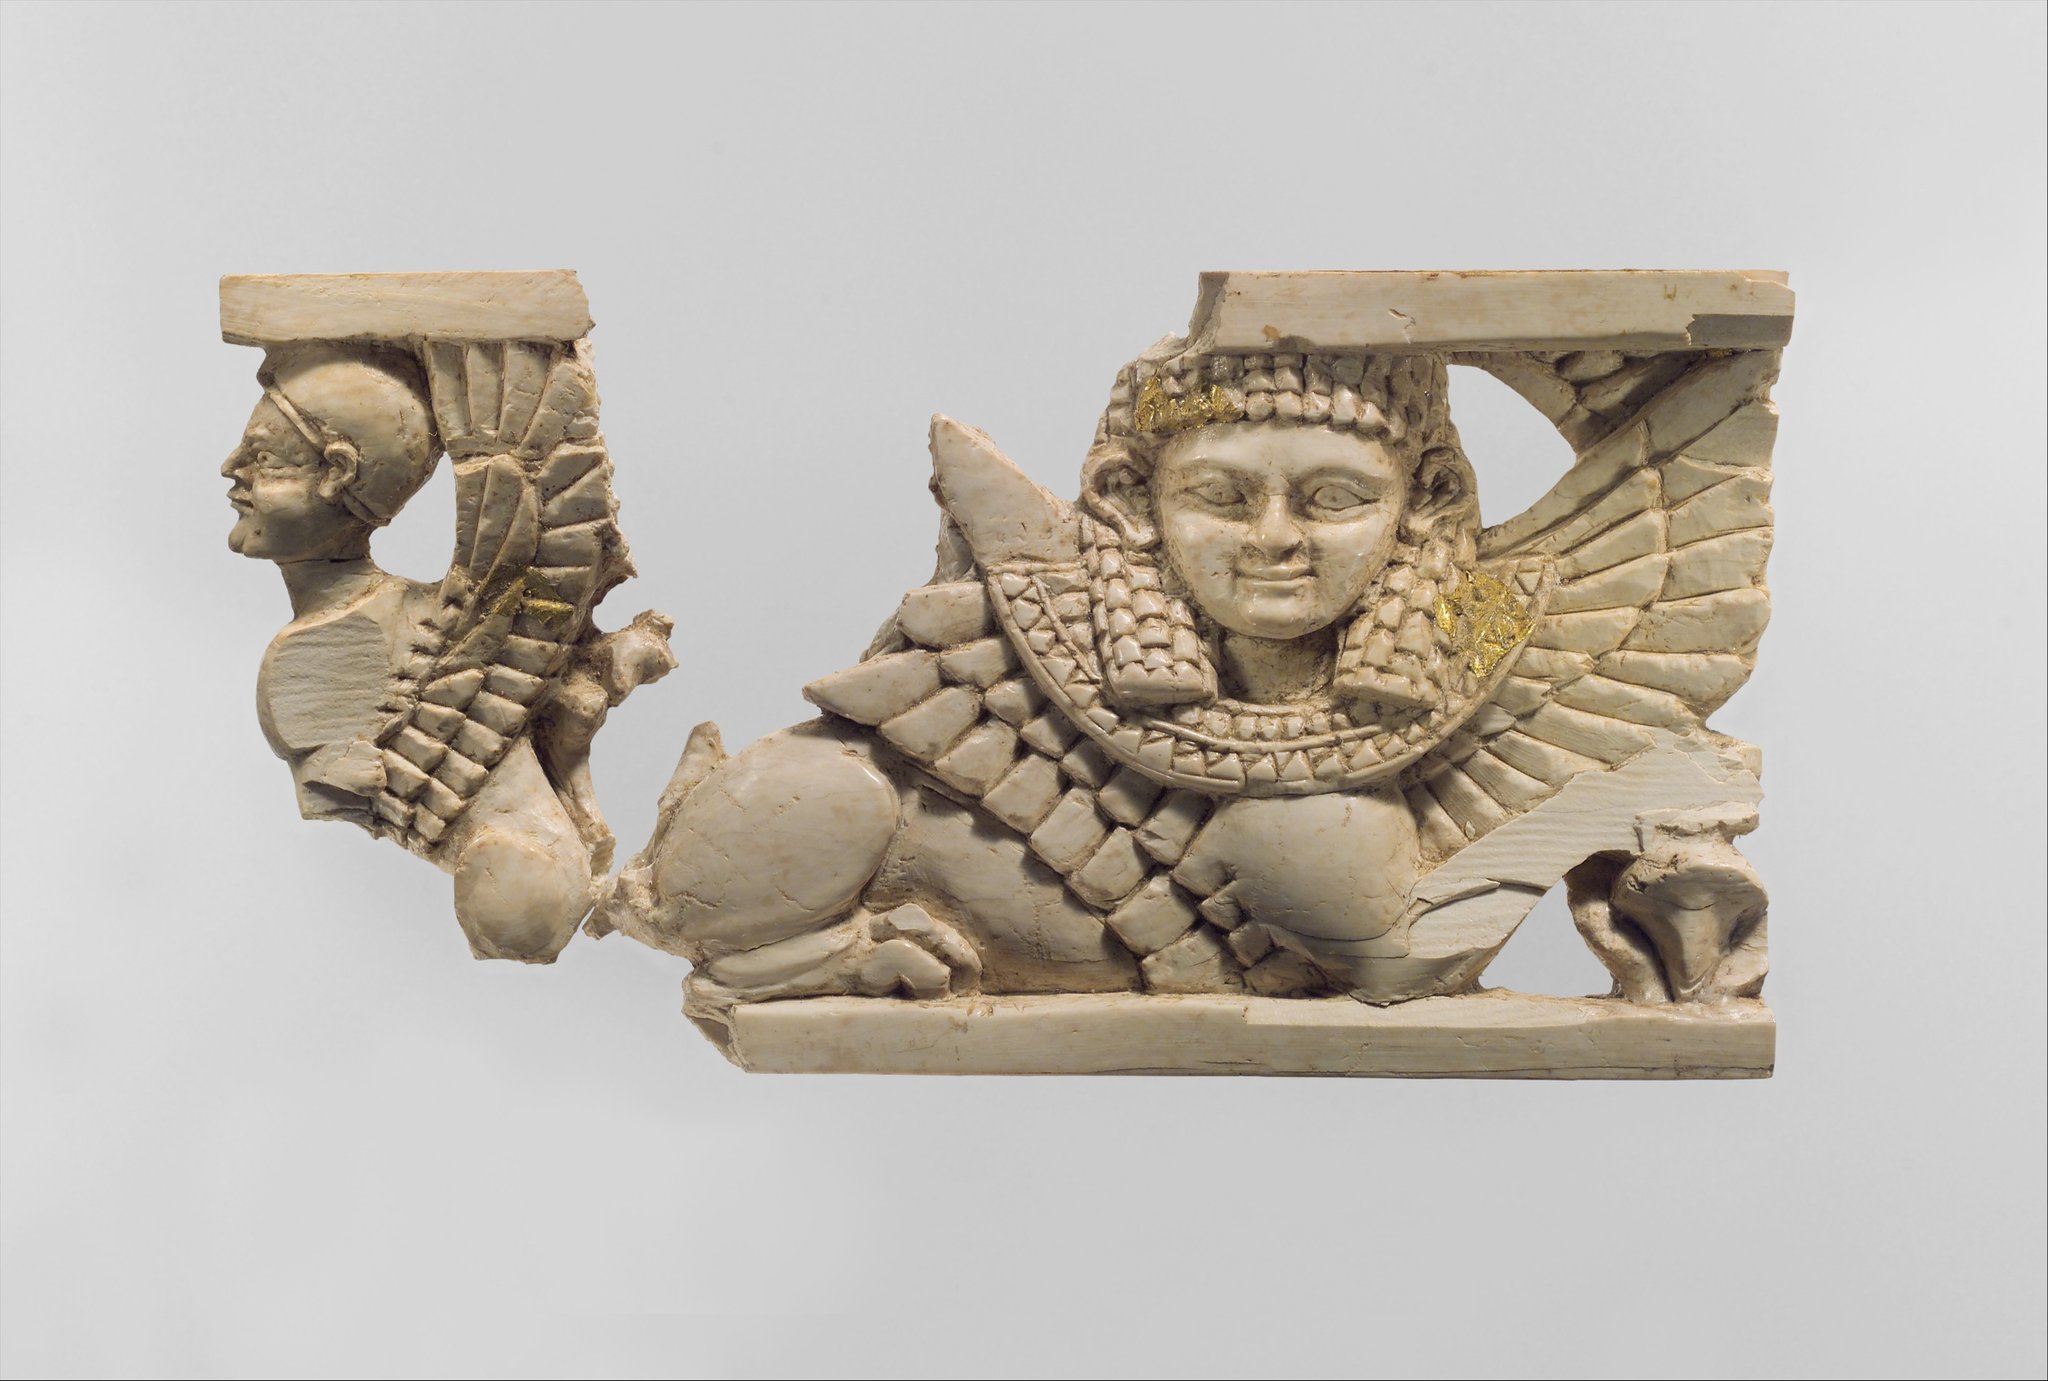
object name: relief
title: Openwork furniture plaque with two sphinxes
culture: assyrian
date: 900-701 BCE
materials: gold foil, ivory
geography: syria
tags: sphinx